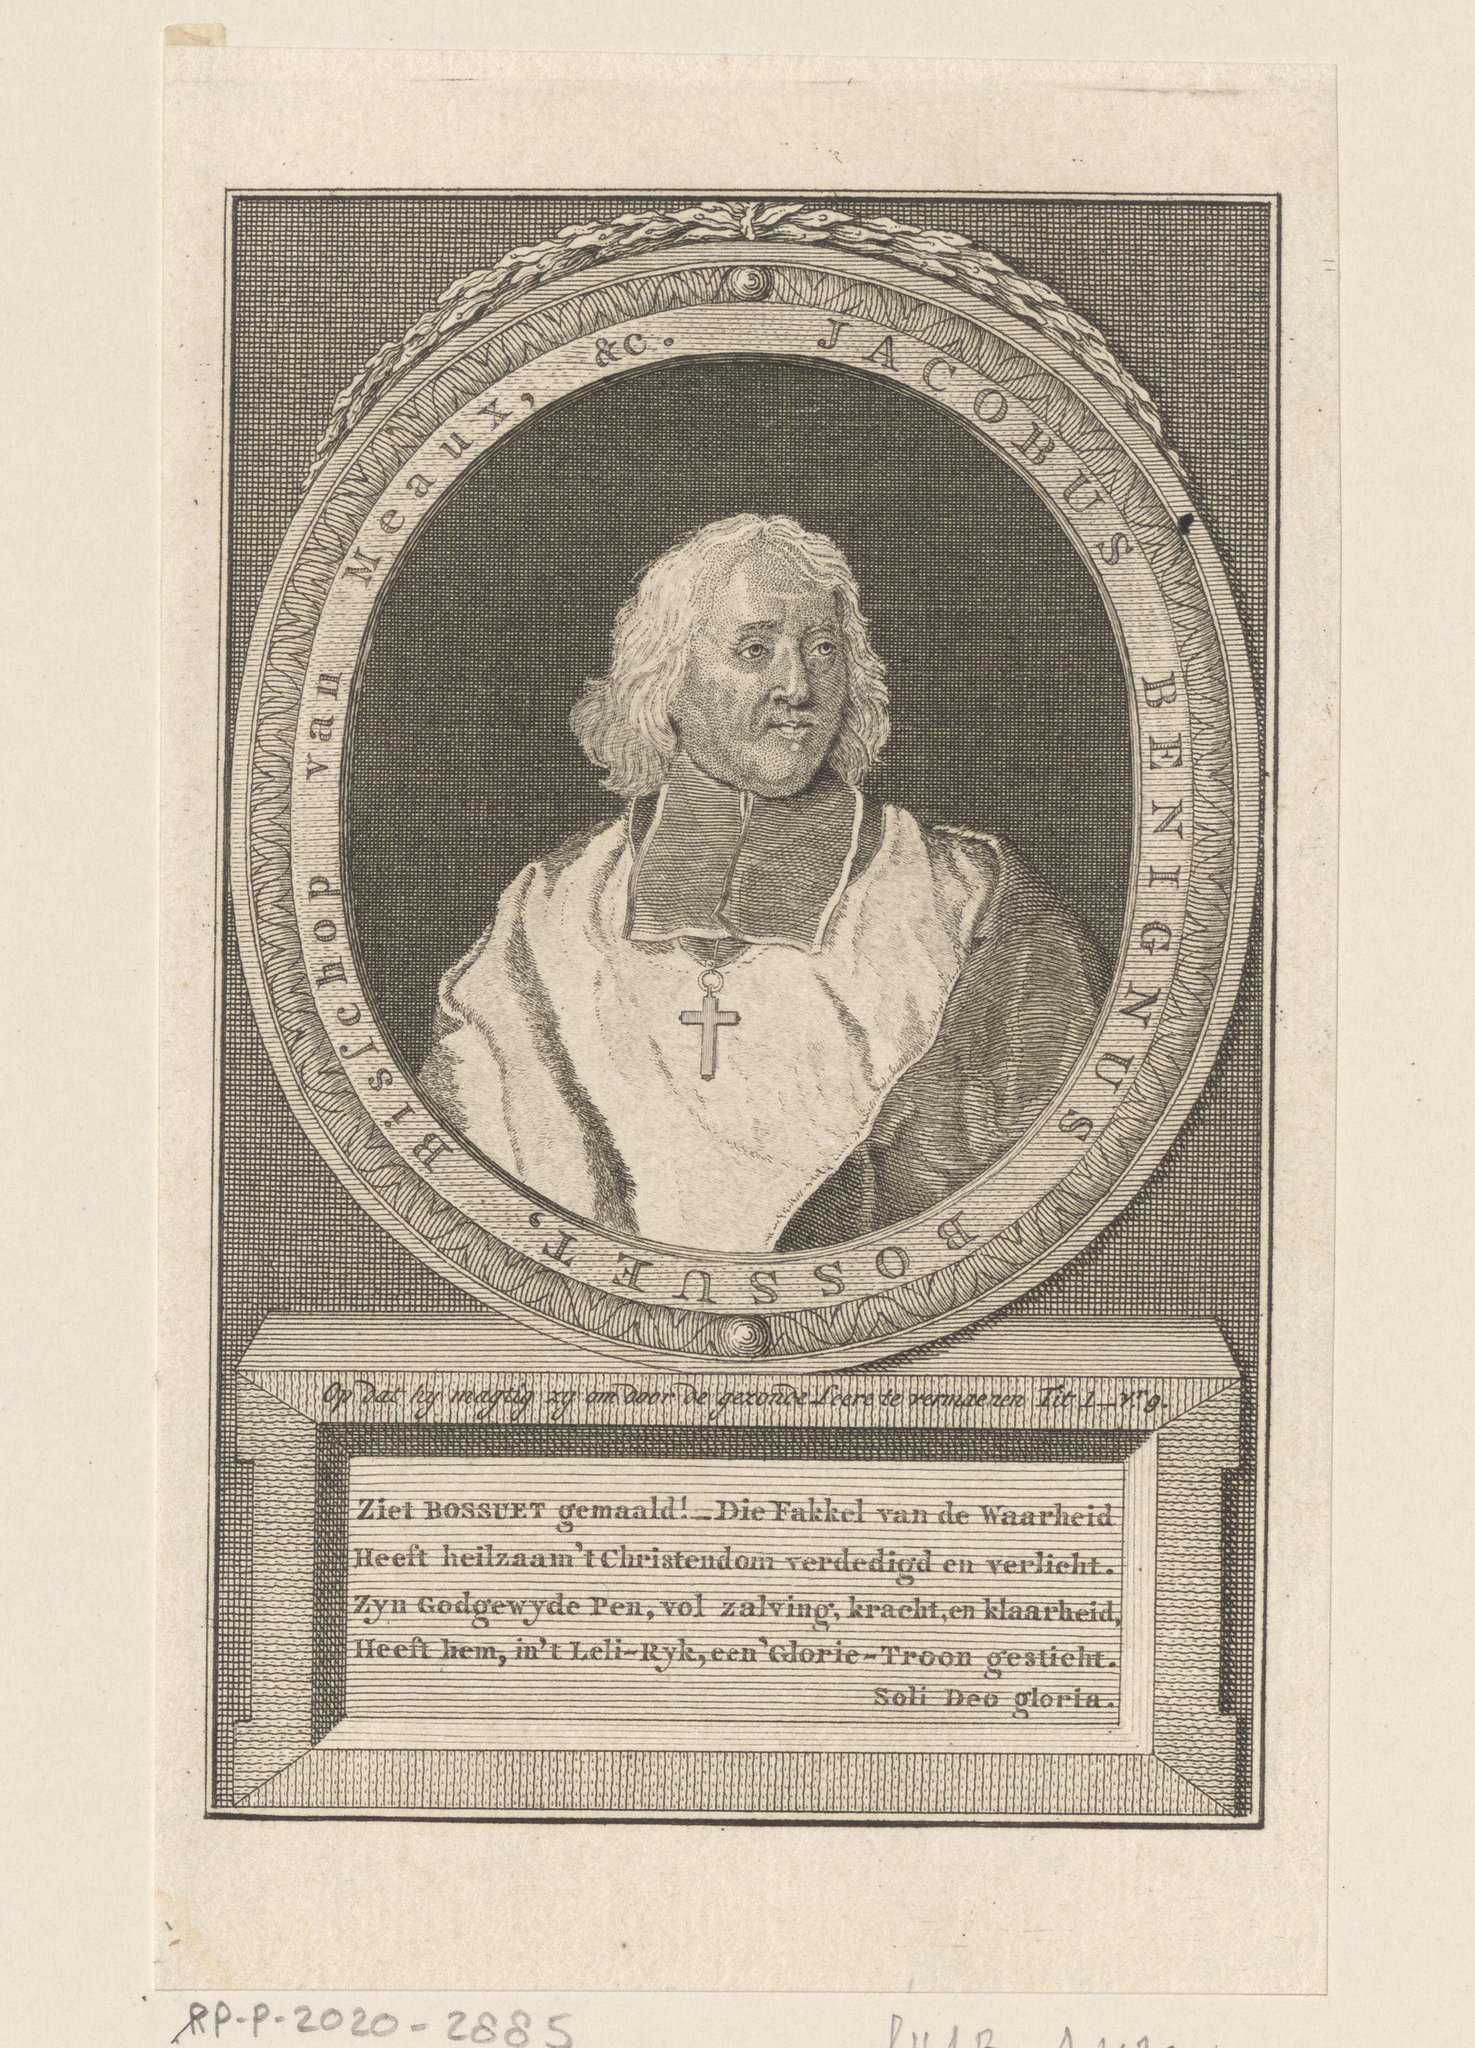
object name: print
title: Portret van Jacques Bénigne Bossuet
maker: Anonymous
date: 1700-1749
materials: paper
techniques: engraving, etching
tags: paris, archbishop, bishop, etc. (roman catholic), historical persons